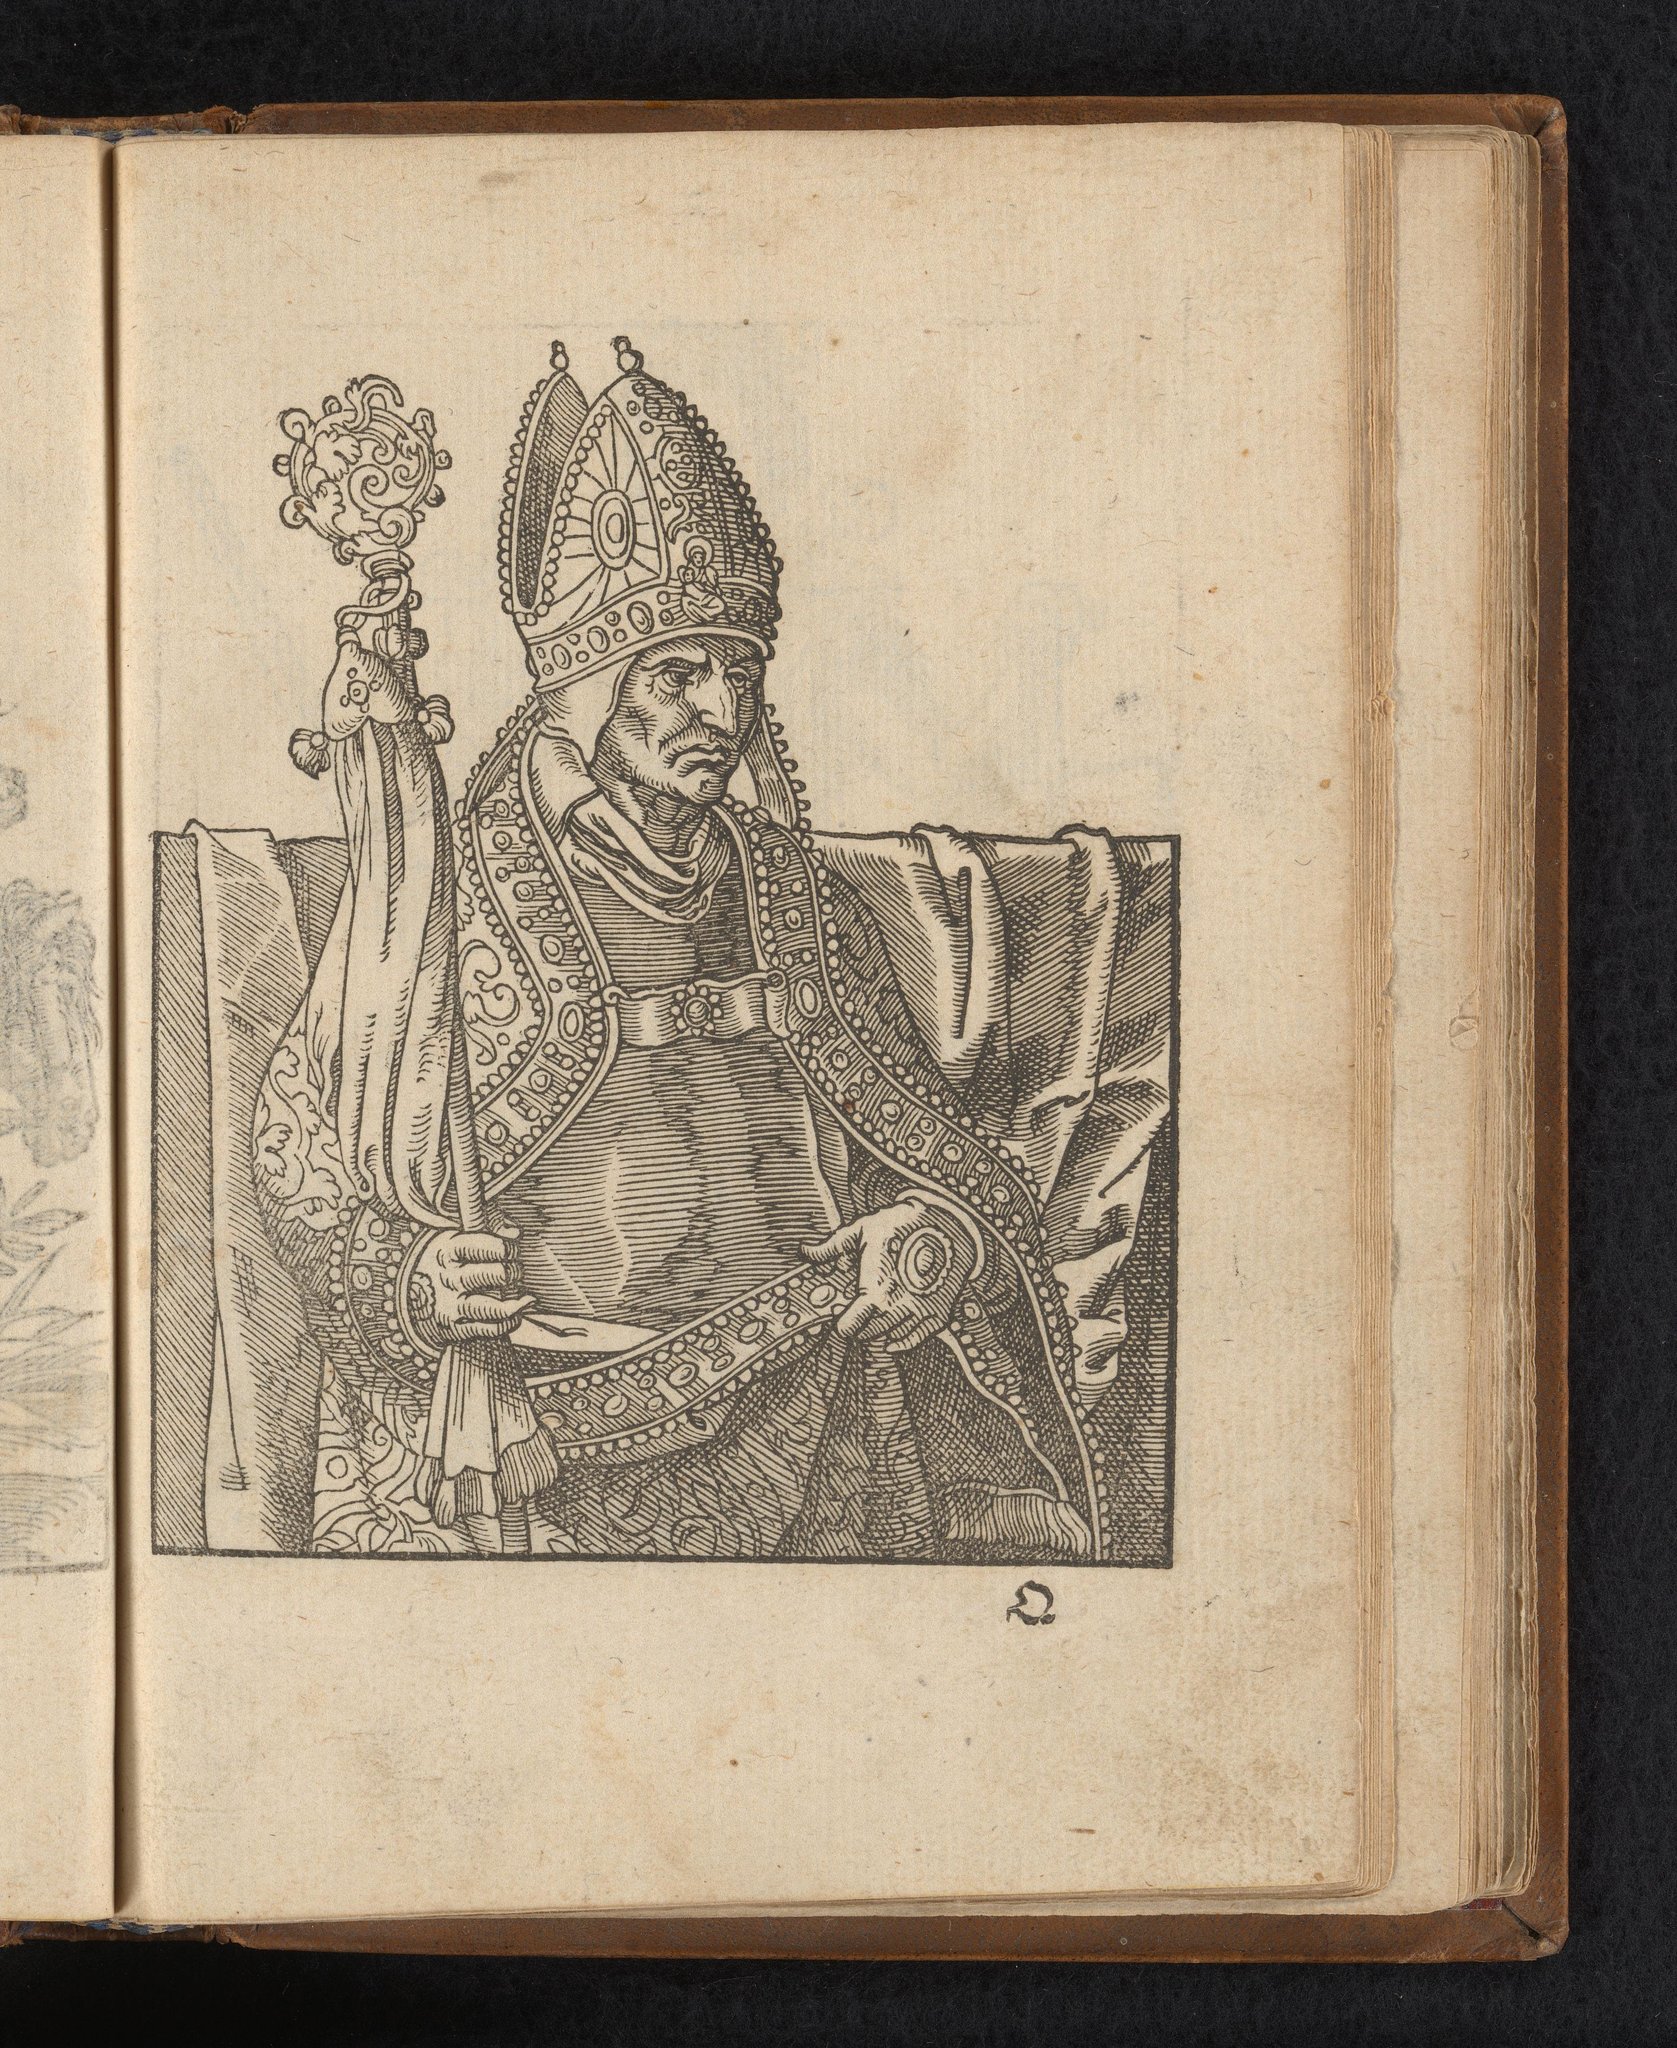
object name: print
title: Bisschop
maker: Anonymous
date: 1578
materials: paper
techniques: woodcut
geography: nuremberg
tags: archbishop, bishop, etc. (roman catholic)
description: Bisschop, halffiguur, naar rechts. Onderdeel van het modelboek Enchiridion artis pingendi, fingendi & sculpendi met 108 figuren bedoeld voor beginnende schilders, beeldhouwers en prentmakers.